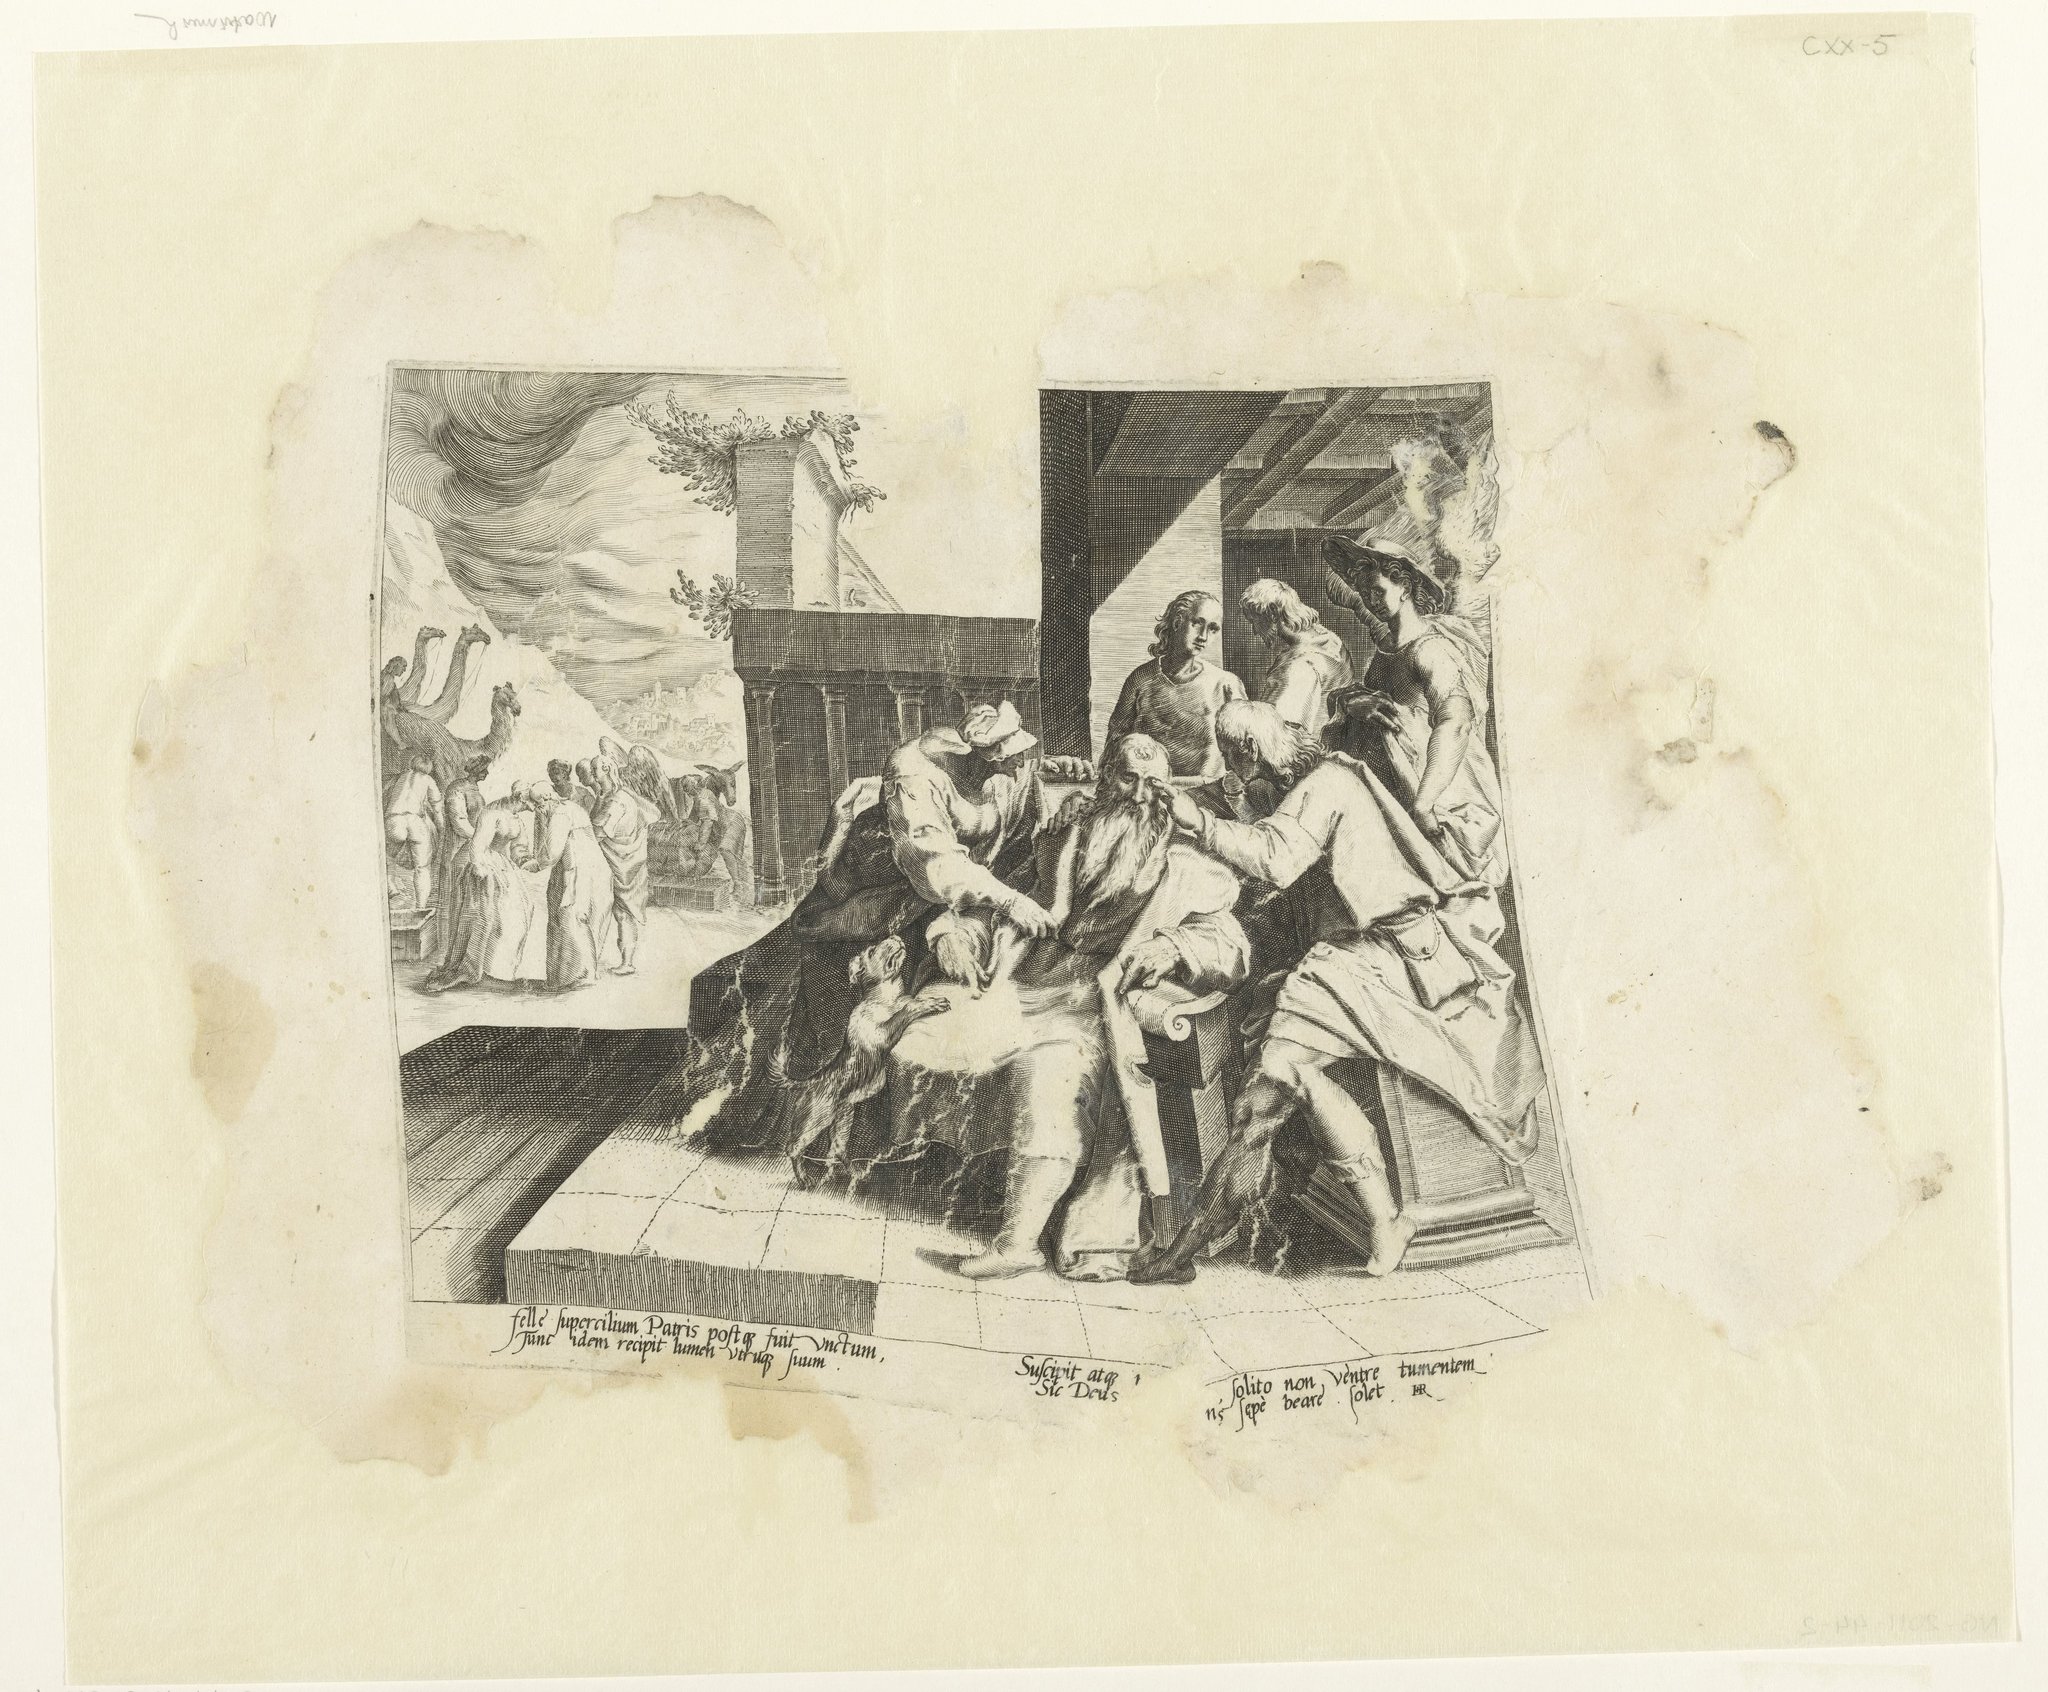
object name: print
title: Geschiedenis van Tobias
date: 1580-1596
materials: paper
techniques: engraving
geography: amsterdam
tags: the healing of tobit: tobias puts the gall of the fish on his father's eyes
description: De prenten in de Nova Zembla collectie zijn tijdens een expeditie van Willem Barendsz en Jacob van Heemskerk in 1596-1597 noodgedwongen in het winterkamp, het ‘Behouden Huis’, op het eiland achtergelaten. De prenten waren in één of meerdere stapels als handelswaar meegenomen vanuit Amsterdam. Bijna drie eeuwen later, in 1871, keerde de Noor Elling Carlsen terug naar Nova Zembla en vond daar de restanten van het ‘Behouden Huis, inclusief een groot deel van de inventaris. Een deel van de prenten, in de vorm van aaneengekoekte kluiten, werd toen ook teruggevonden. De papierkluiten waren soms op meerdere plekken gebroken. Tussen 1975-1979 zijn de prenten van elkaar gescheiden. Dit leverde in totaal ca. 1000 fragmenten van ca. 400 afdrukken van ca. 150 verschillende prenten op. Voor zover mogelijk zijn de fragmenten samengevoegd en zijn de prenten gereconstrueerd.